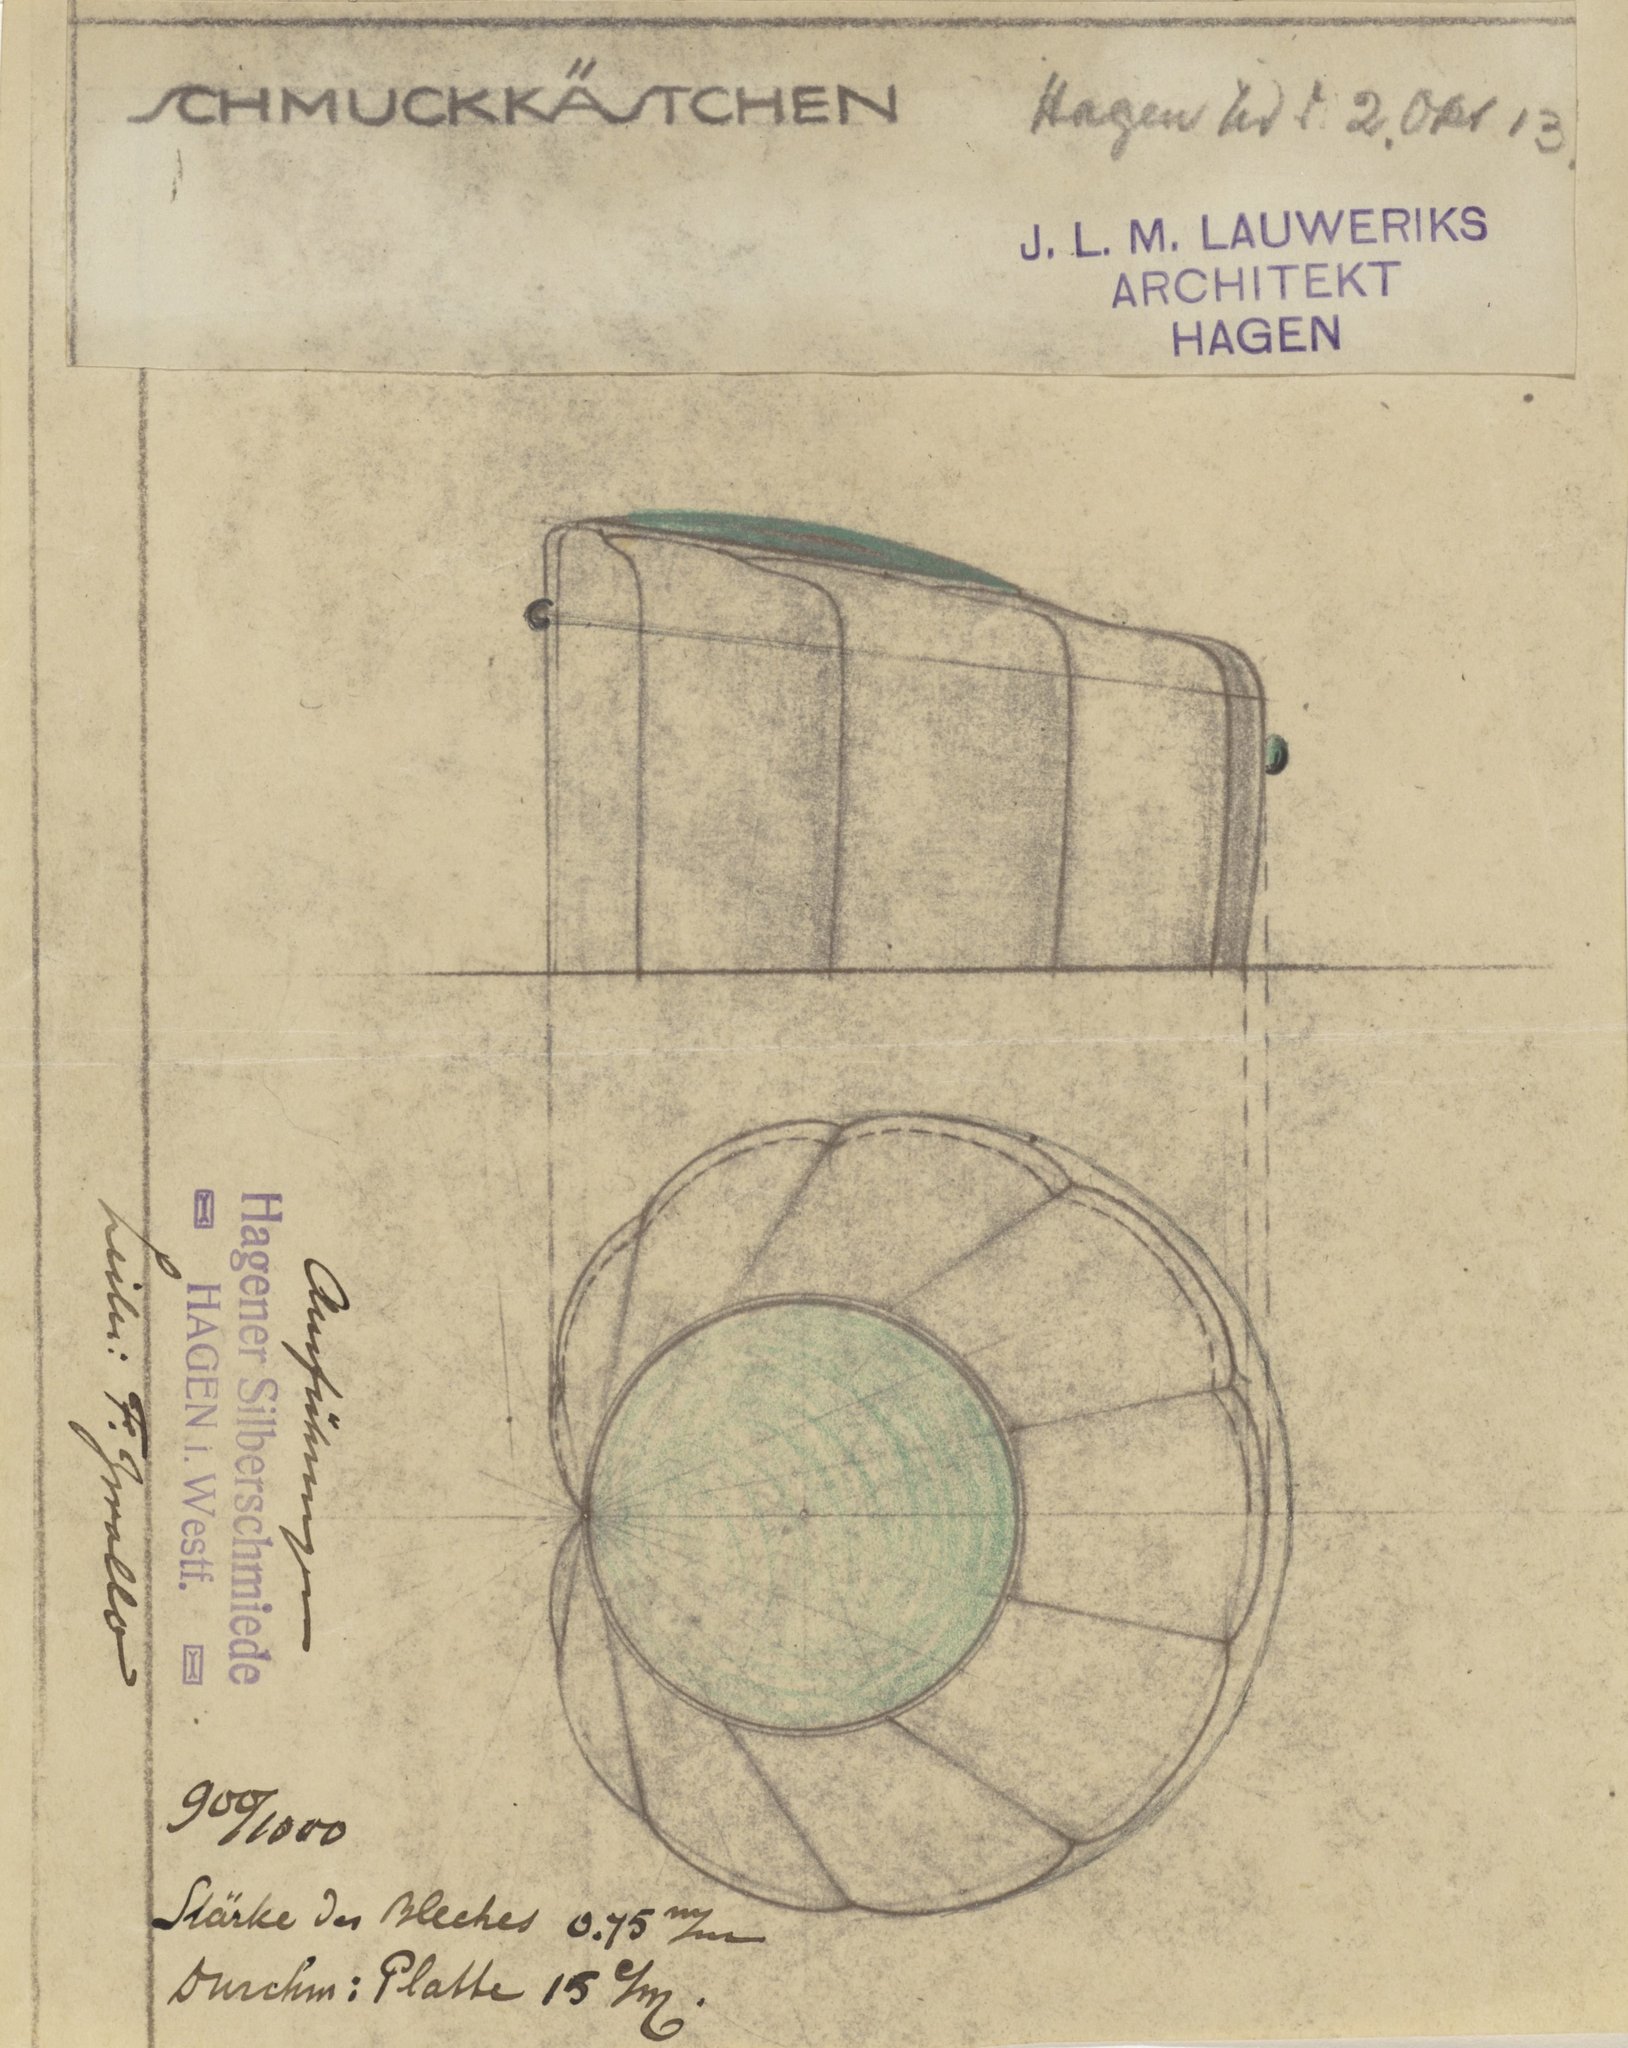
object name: design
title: Ontwerpen voor een juwelenkist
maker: mathieu lauweriks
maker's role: designer, draughtsman, print maker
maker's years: 1864-1932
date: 1913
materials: paper, pencil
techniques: blueprint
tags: jewel-box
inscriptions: date: ‘2 Okt. 13’